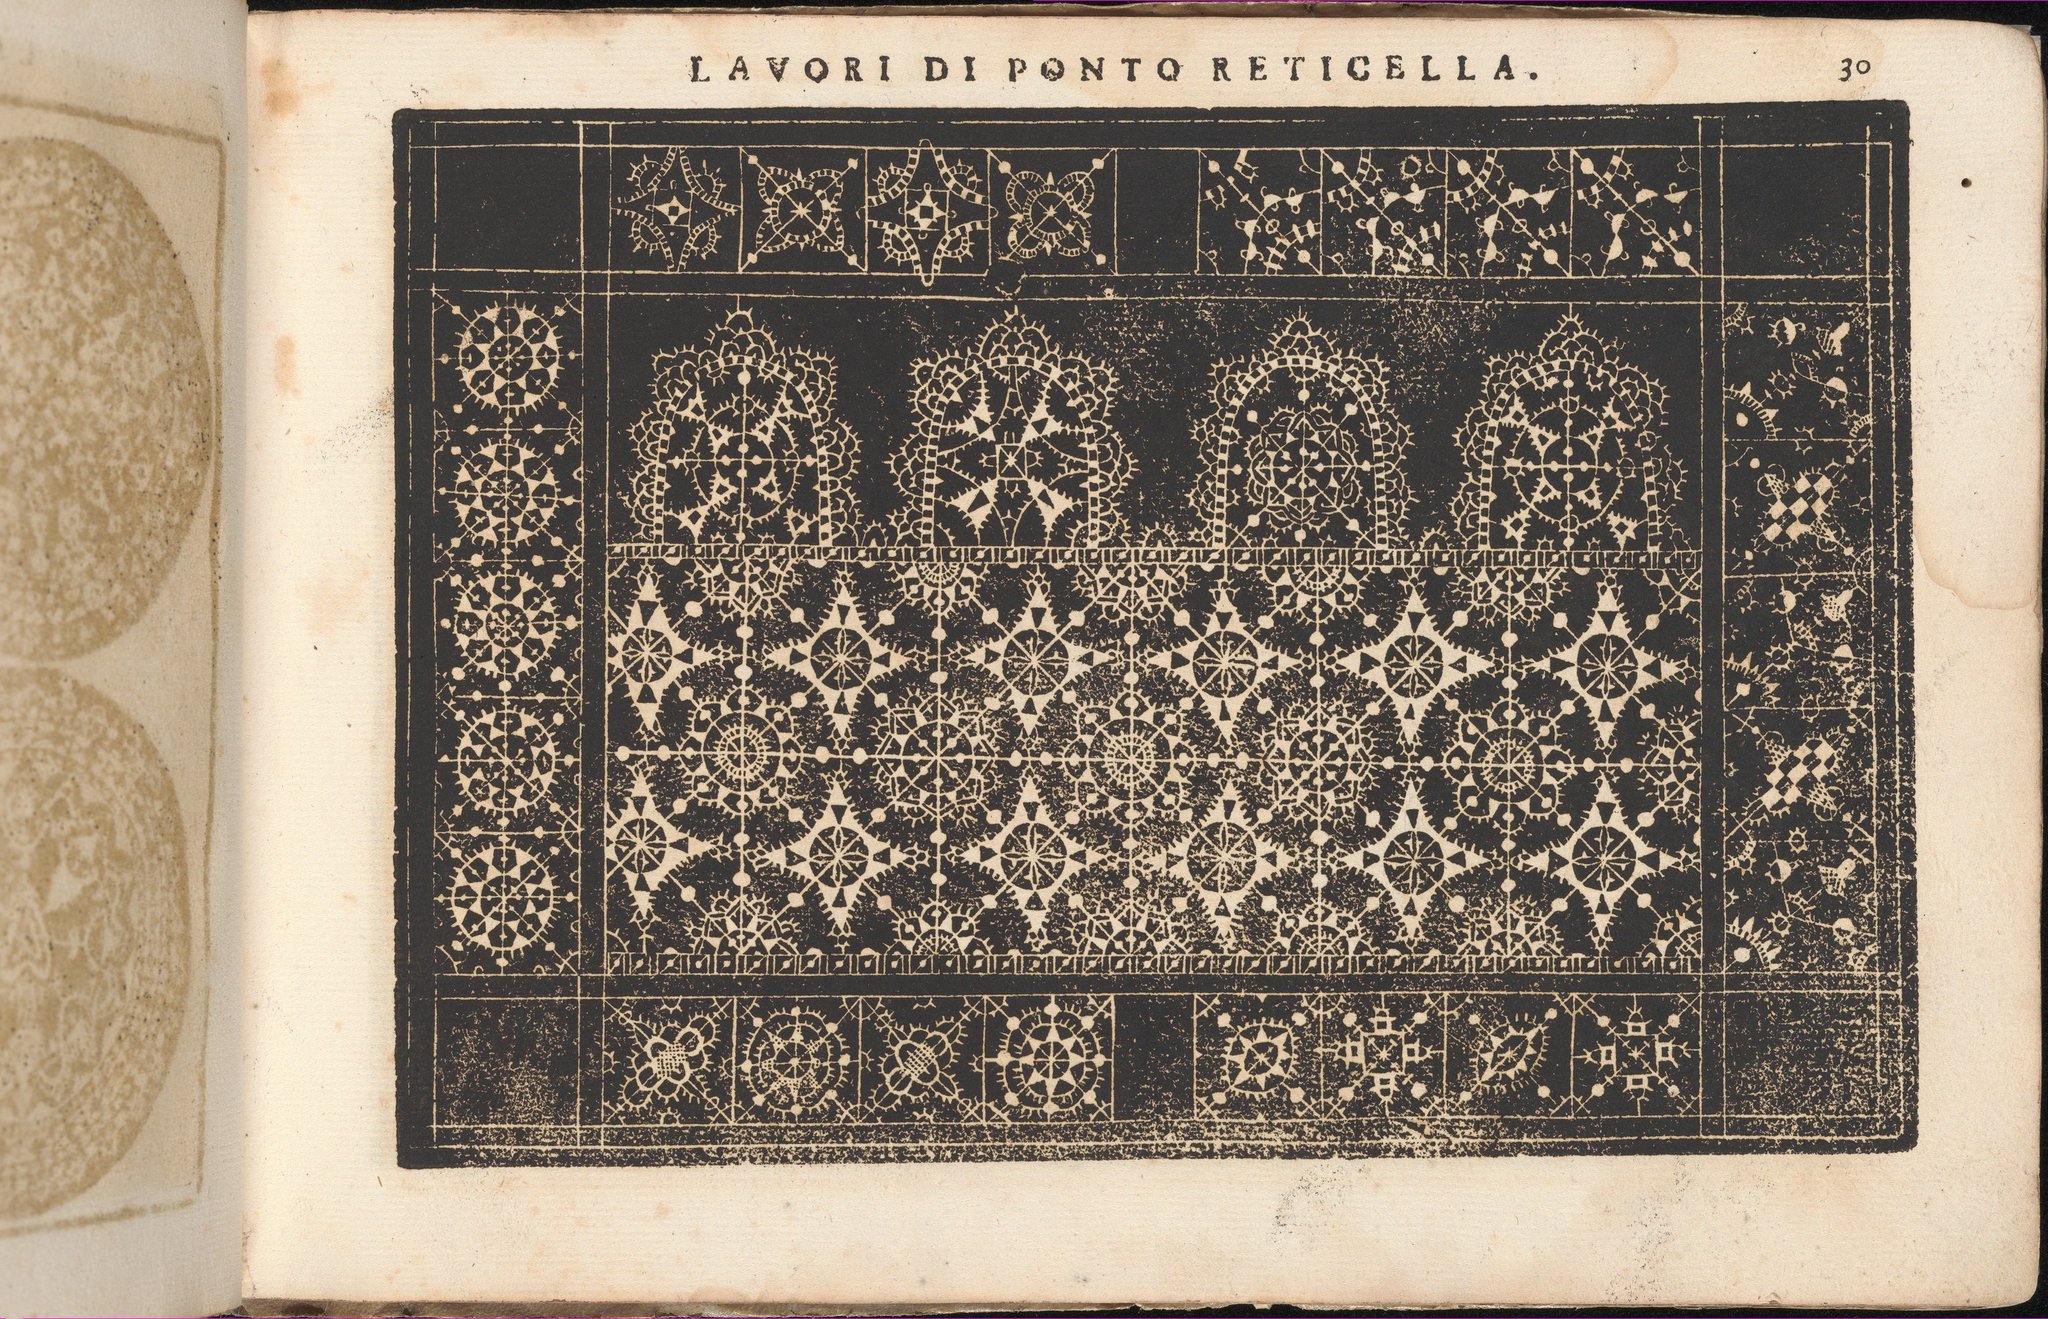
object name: book print ornament architecture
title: Teatro delle Nobili et Virtuose Donne..., page 28 (recto)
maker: isabella catanea parasole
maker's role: author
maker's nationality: italian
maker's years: 1565-1625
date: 1616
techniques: engraving, woodcut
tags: flowers